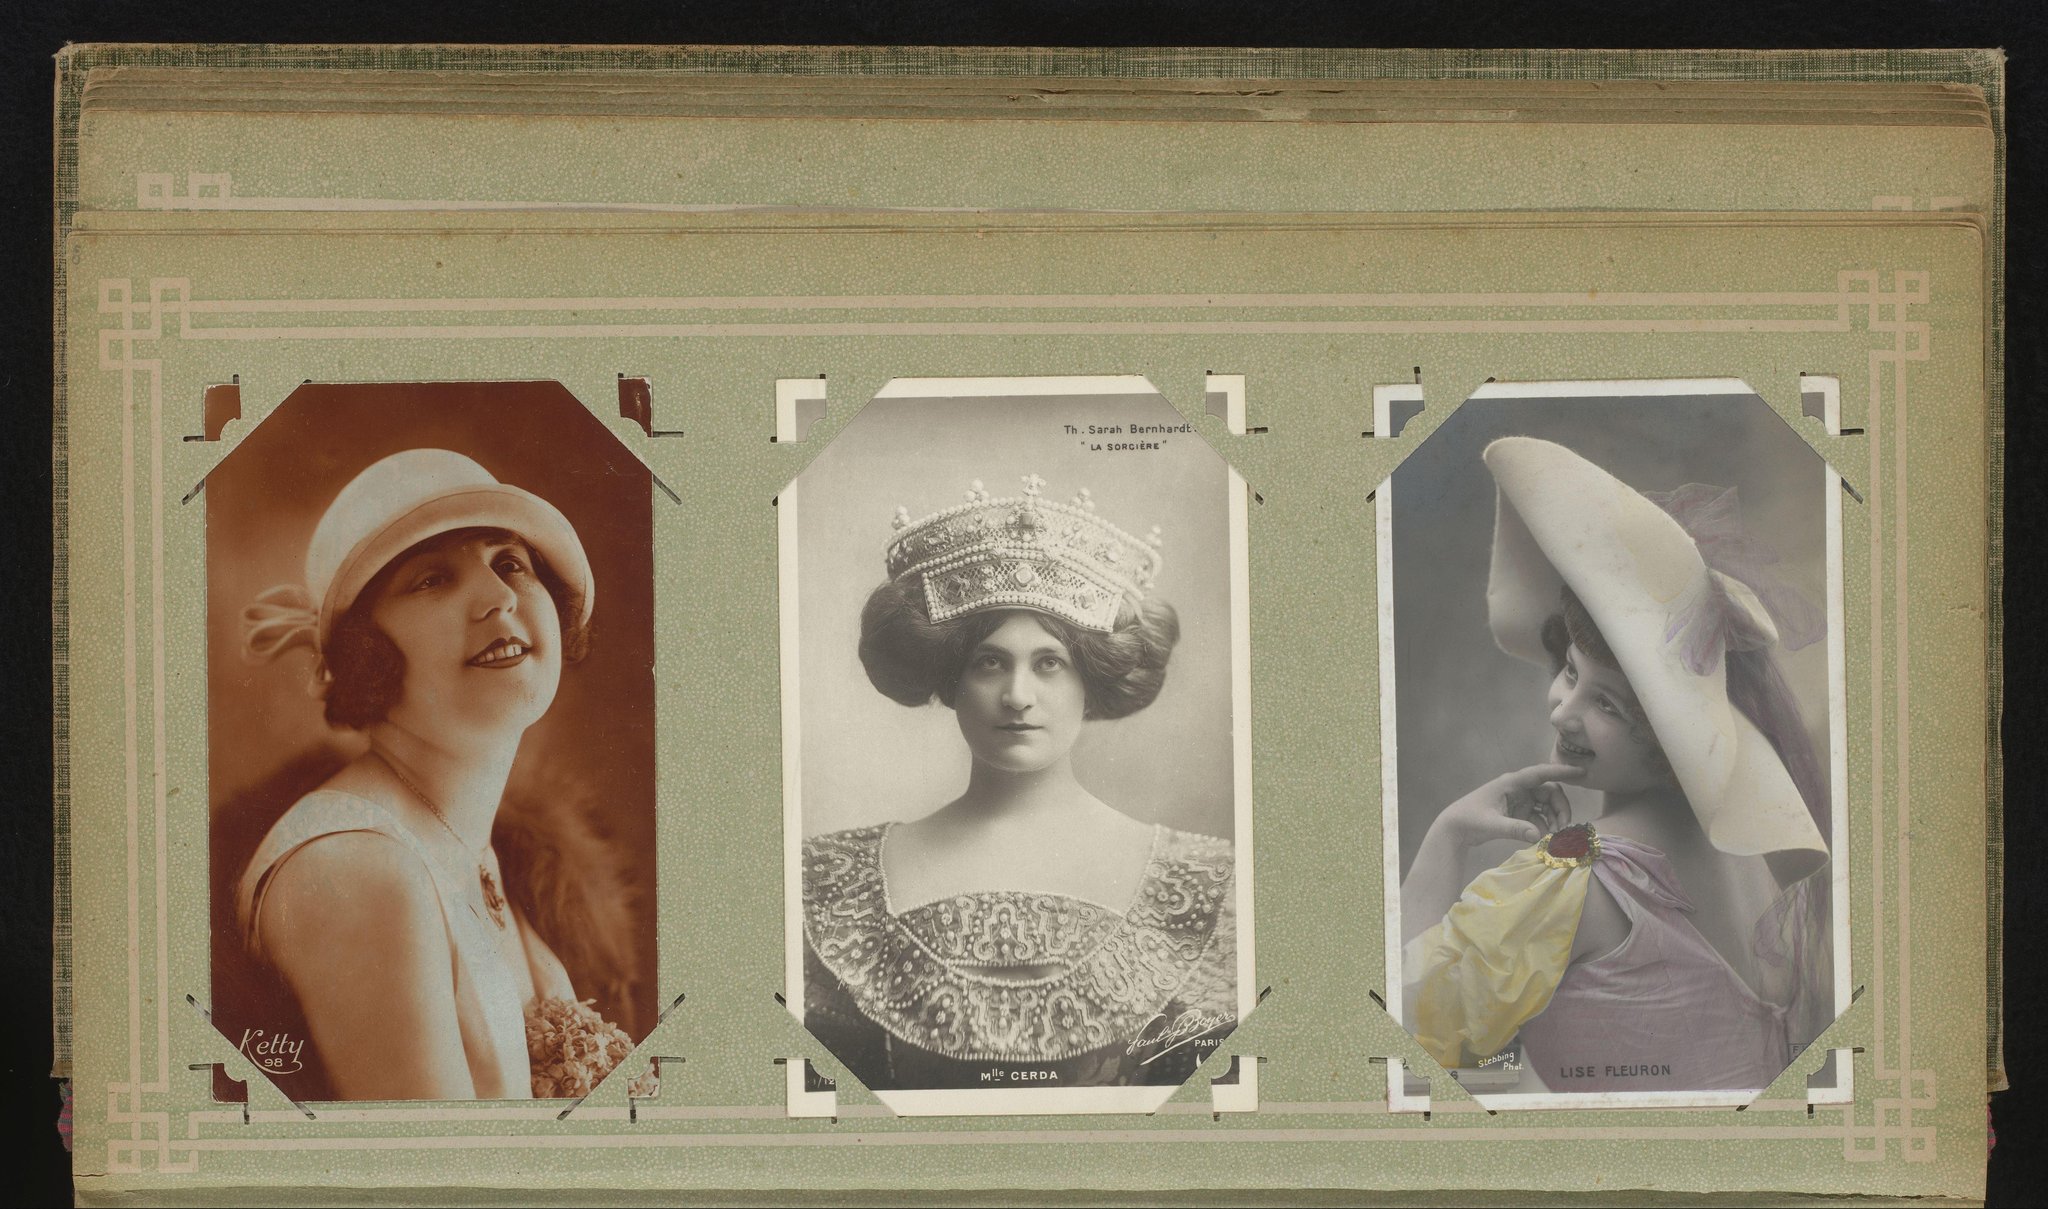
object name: ansichtkaart, prentbriefkaart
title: Drie portretten van actrices, onder wie Lise Fleuron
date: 1900-1930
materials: cardboard, photographic support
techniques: gelatin silver print, hand coloring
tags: historical persons - bb - woman, portrait of actor, actress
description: Deze foto's maken deel uit van een album.